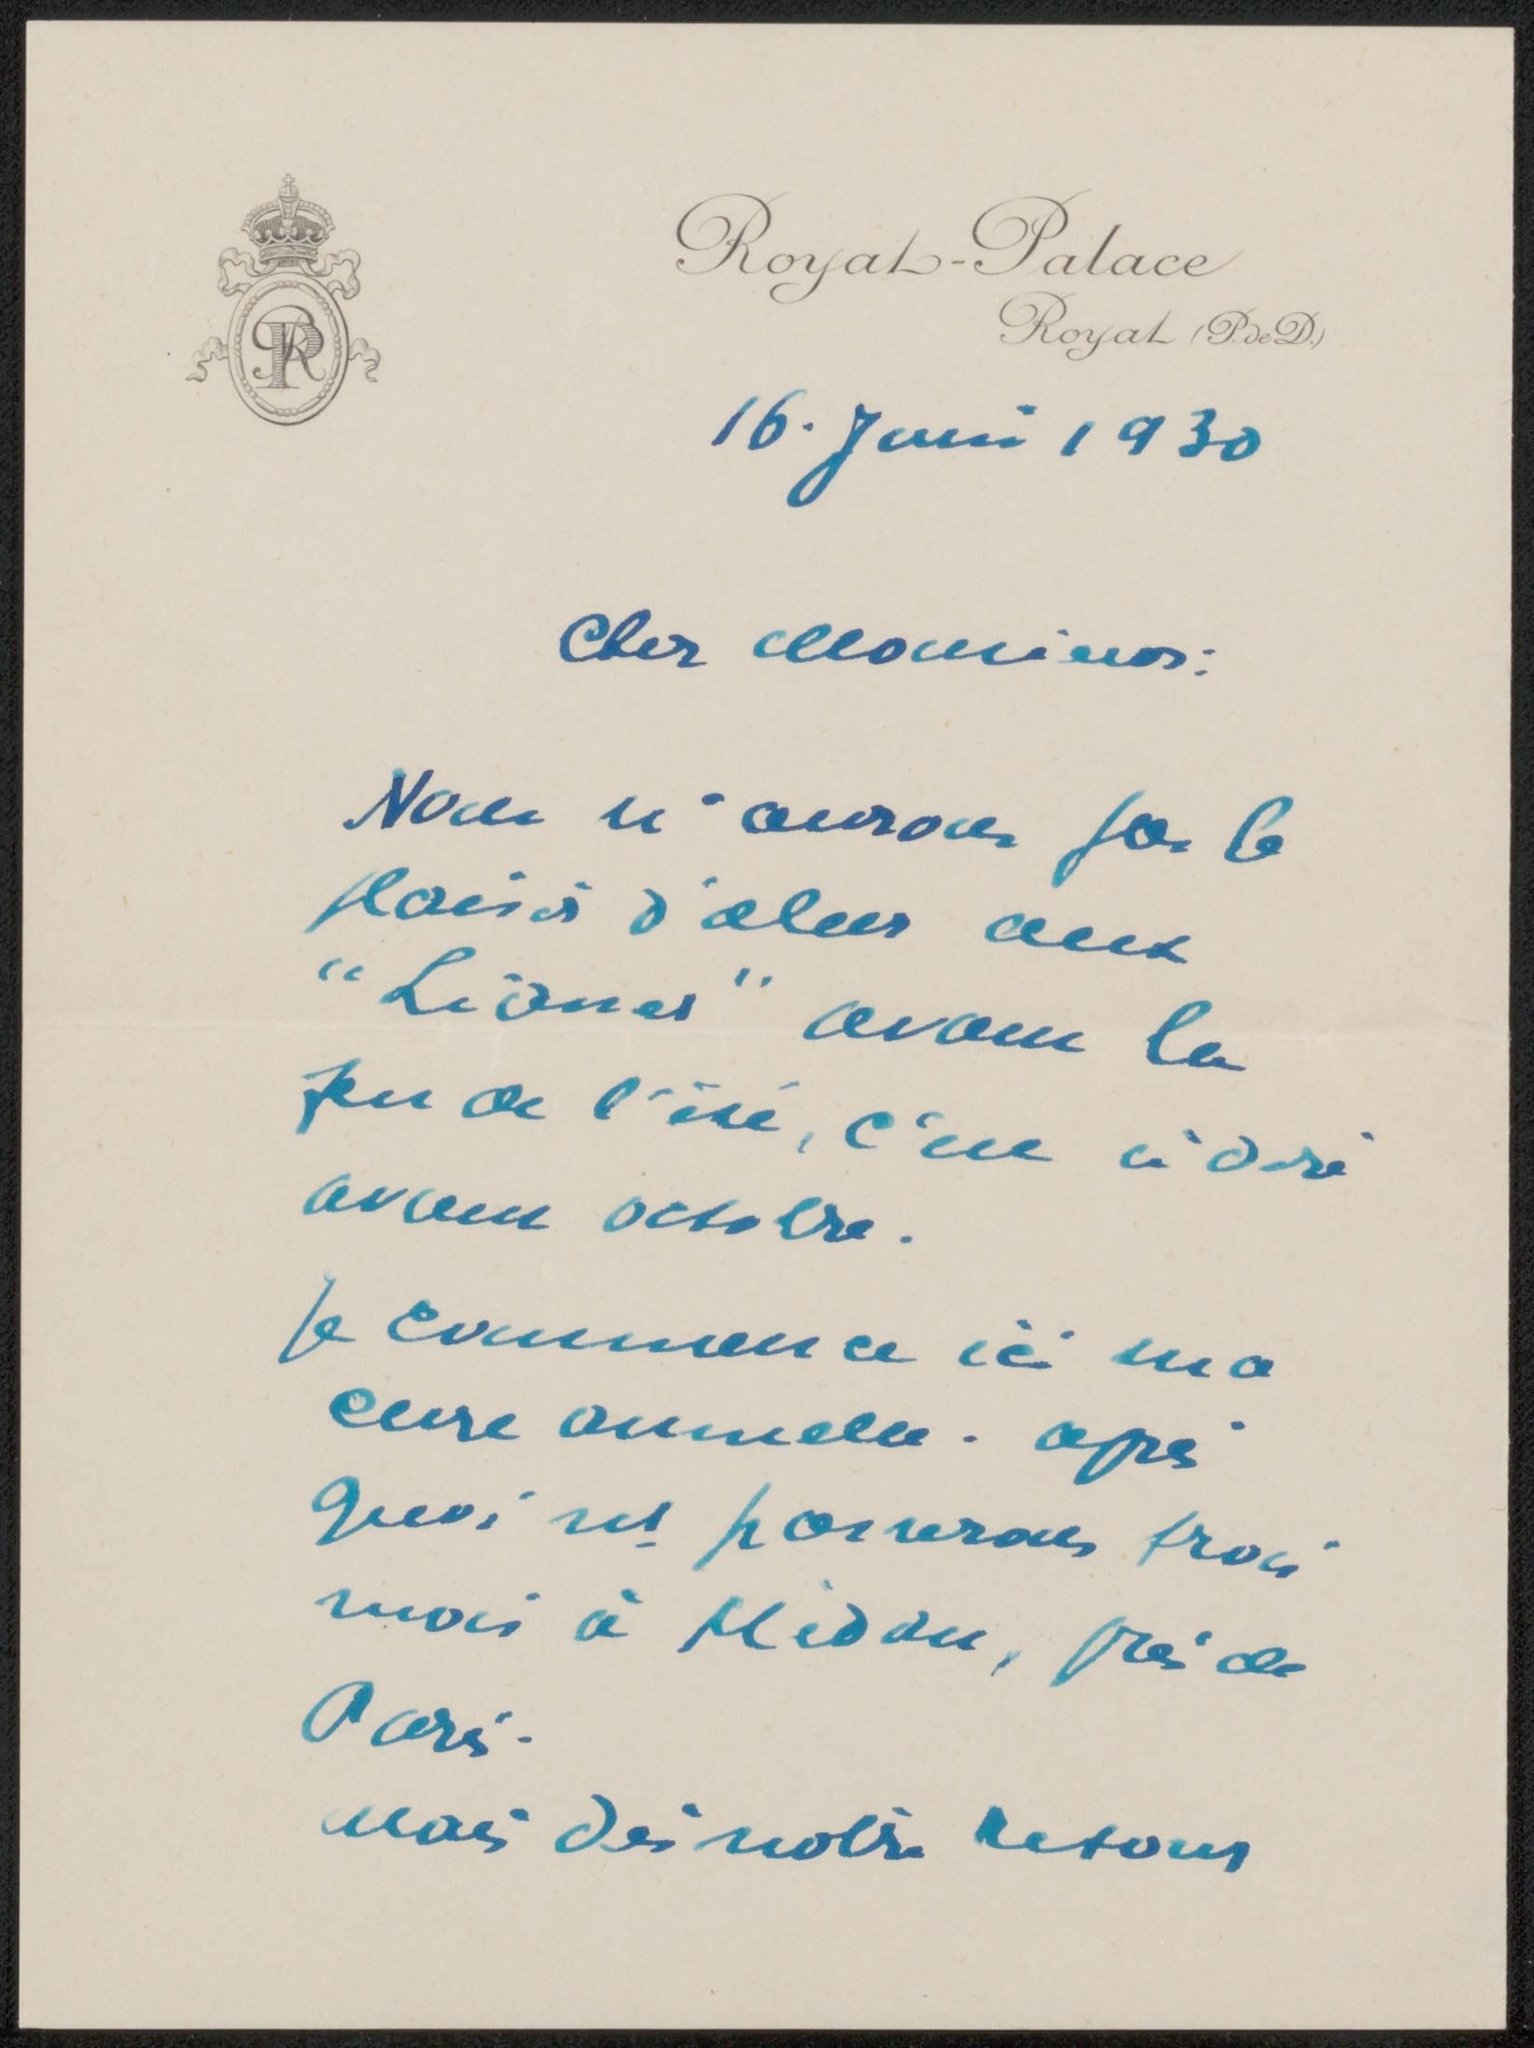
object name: letter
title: Brief aan Philip Zilcken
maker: maurice maeterlinck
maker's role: dichter, essayist, toneelschrijver, vertaler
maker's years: 1862-1949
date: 1930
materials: ink, paper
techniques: pen, printing, writing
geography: royat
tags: the hague, painter, philip zilcken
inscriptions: collector's mark: ‘RPK’